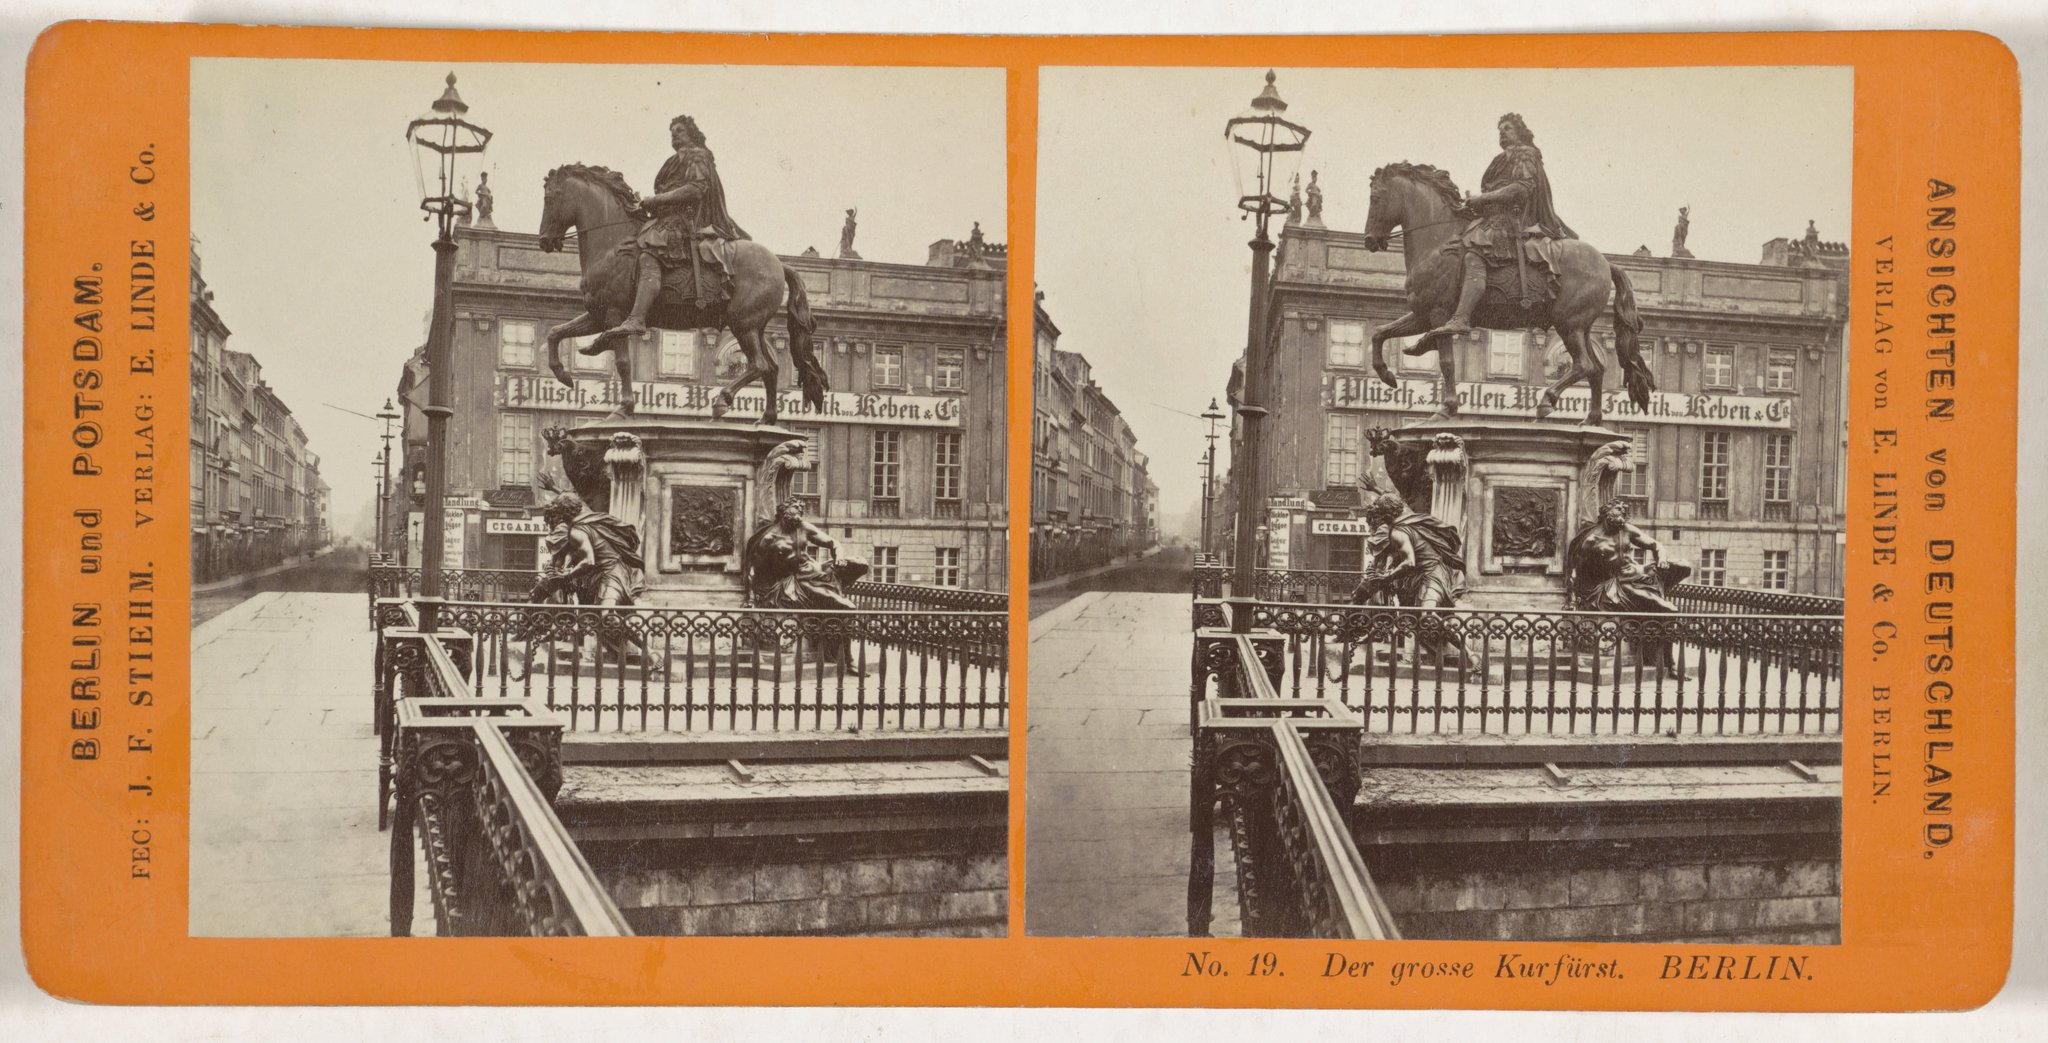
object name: stereograph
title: Standbeeld van Frederik Willem I van Brandenburg te paard op de Lange Brücke, Berlijn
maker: johann friedrich stiehm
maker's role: fotograaf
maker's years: 1826-1902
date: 1868-1870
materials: cardboard, paper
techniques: albumen print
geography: berlin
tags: berlin, frederik willem van brandenburg (i), monument, statue, bridge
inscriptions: number: ‘No. 19.’